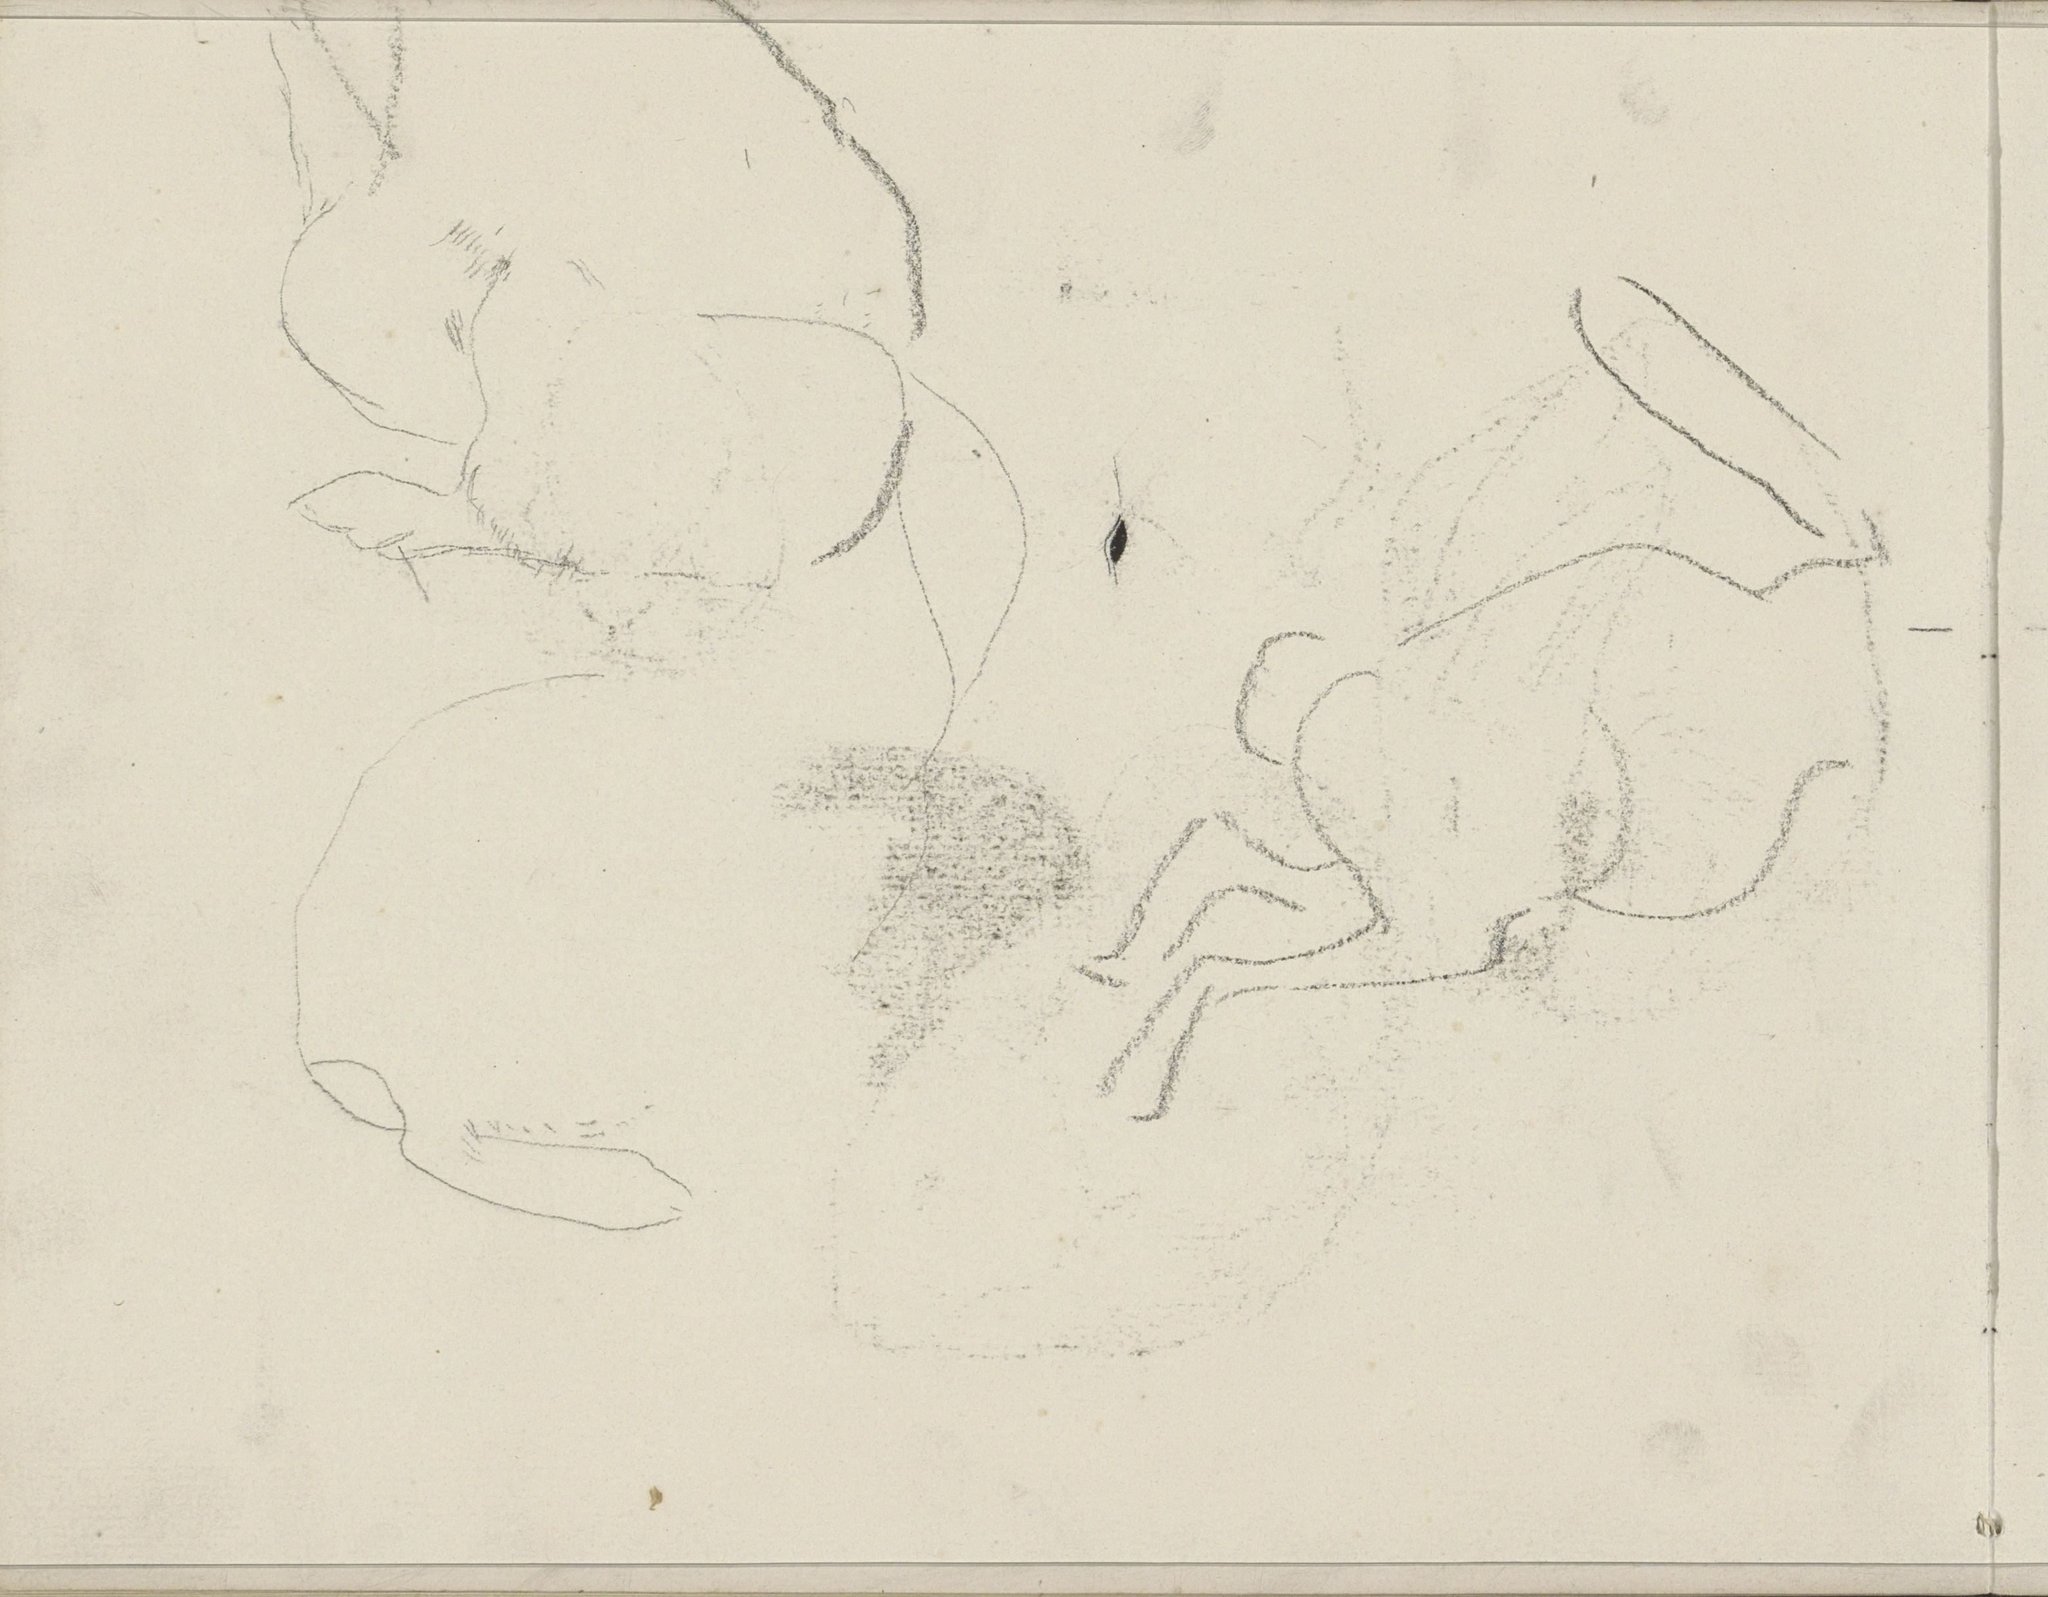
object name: sketchbook leaf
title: Konijnen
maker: carel adolph lion cachet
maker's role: draughtsman, print maker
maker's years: 1864-1945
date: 1896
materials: chalk, paper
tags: rodents: rabbit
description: Blad 19 verso uit een schetsboek met 44 bladen.